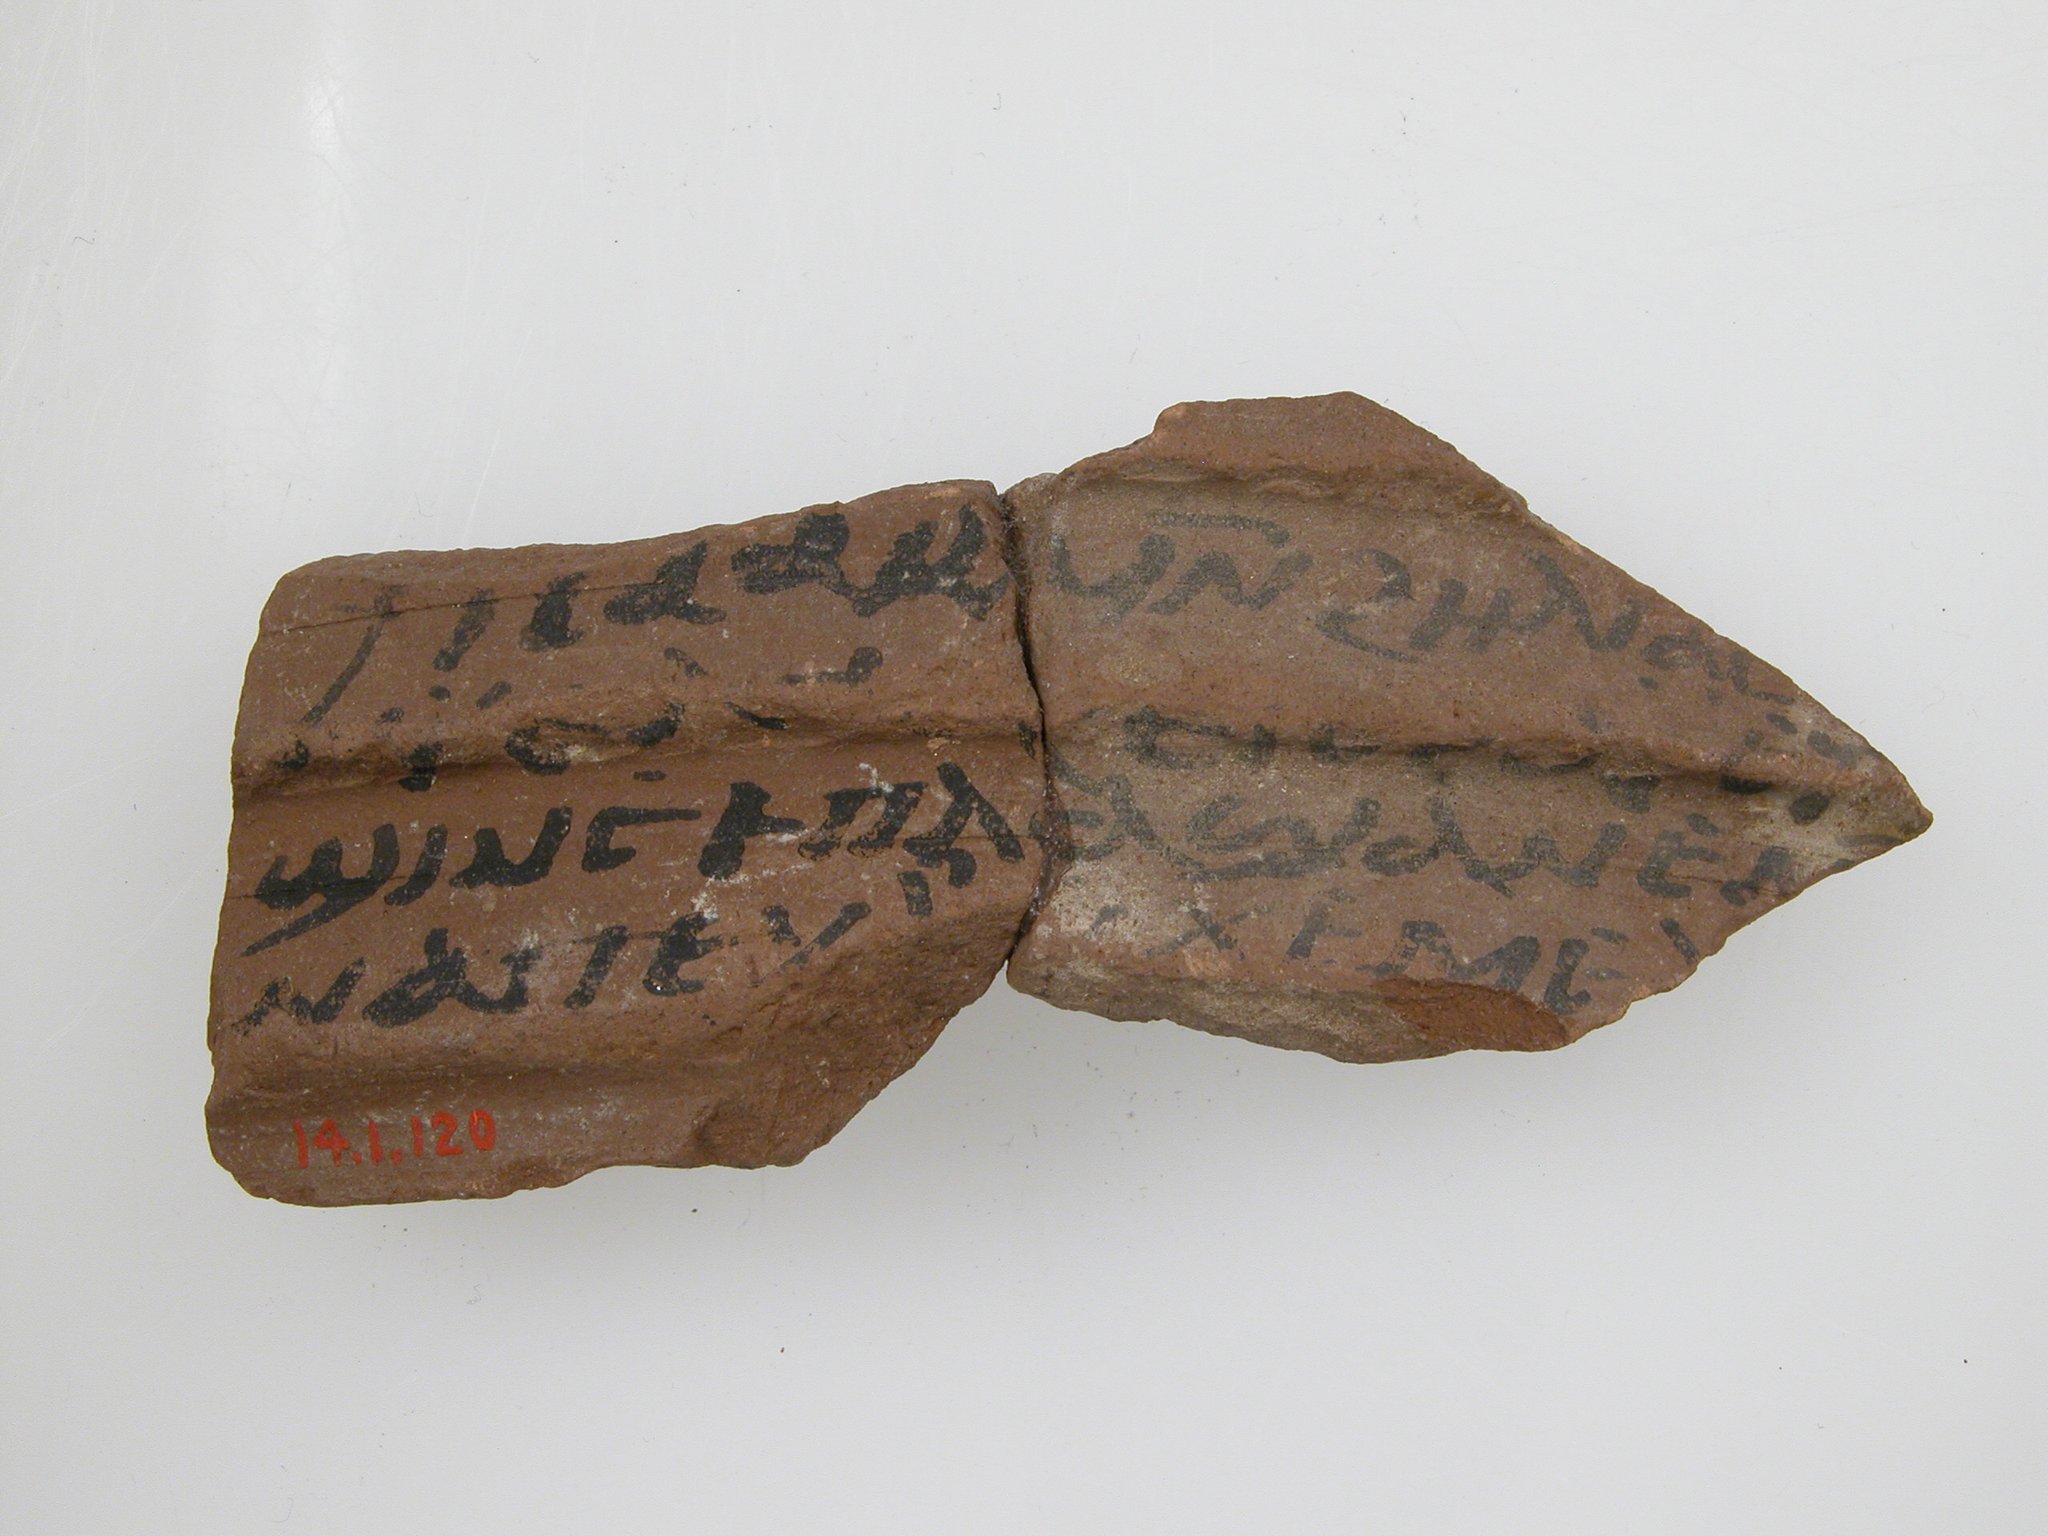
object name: ostrakon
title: Ostrakon with a Letter from Isaac and Elias to Lashane of Jeme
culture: coptic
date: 600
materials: ink, pottery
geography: egypt